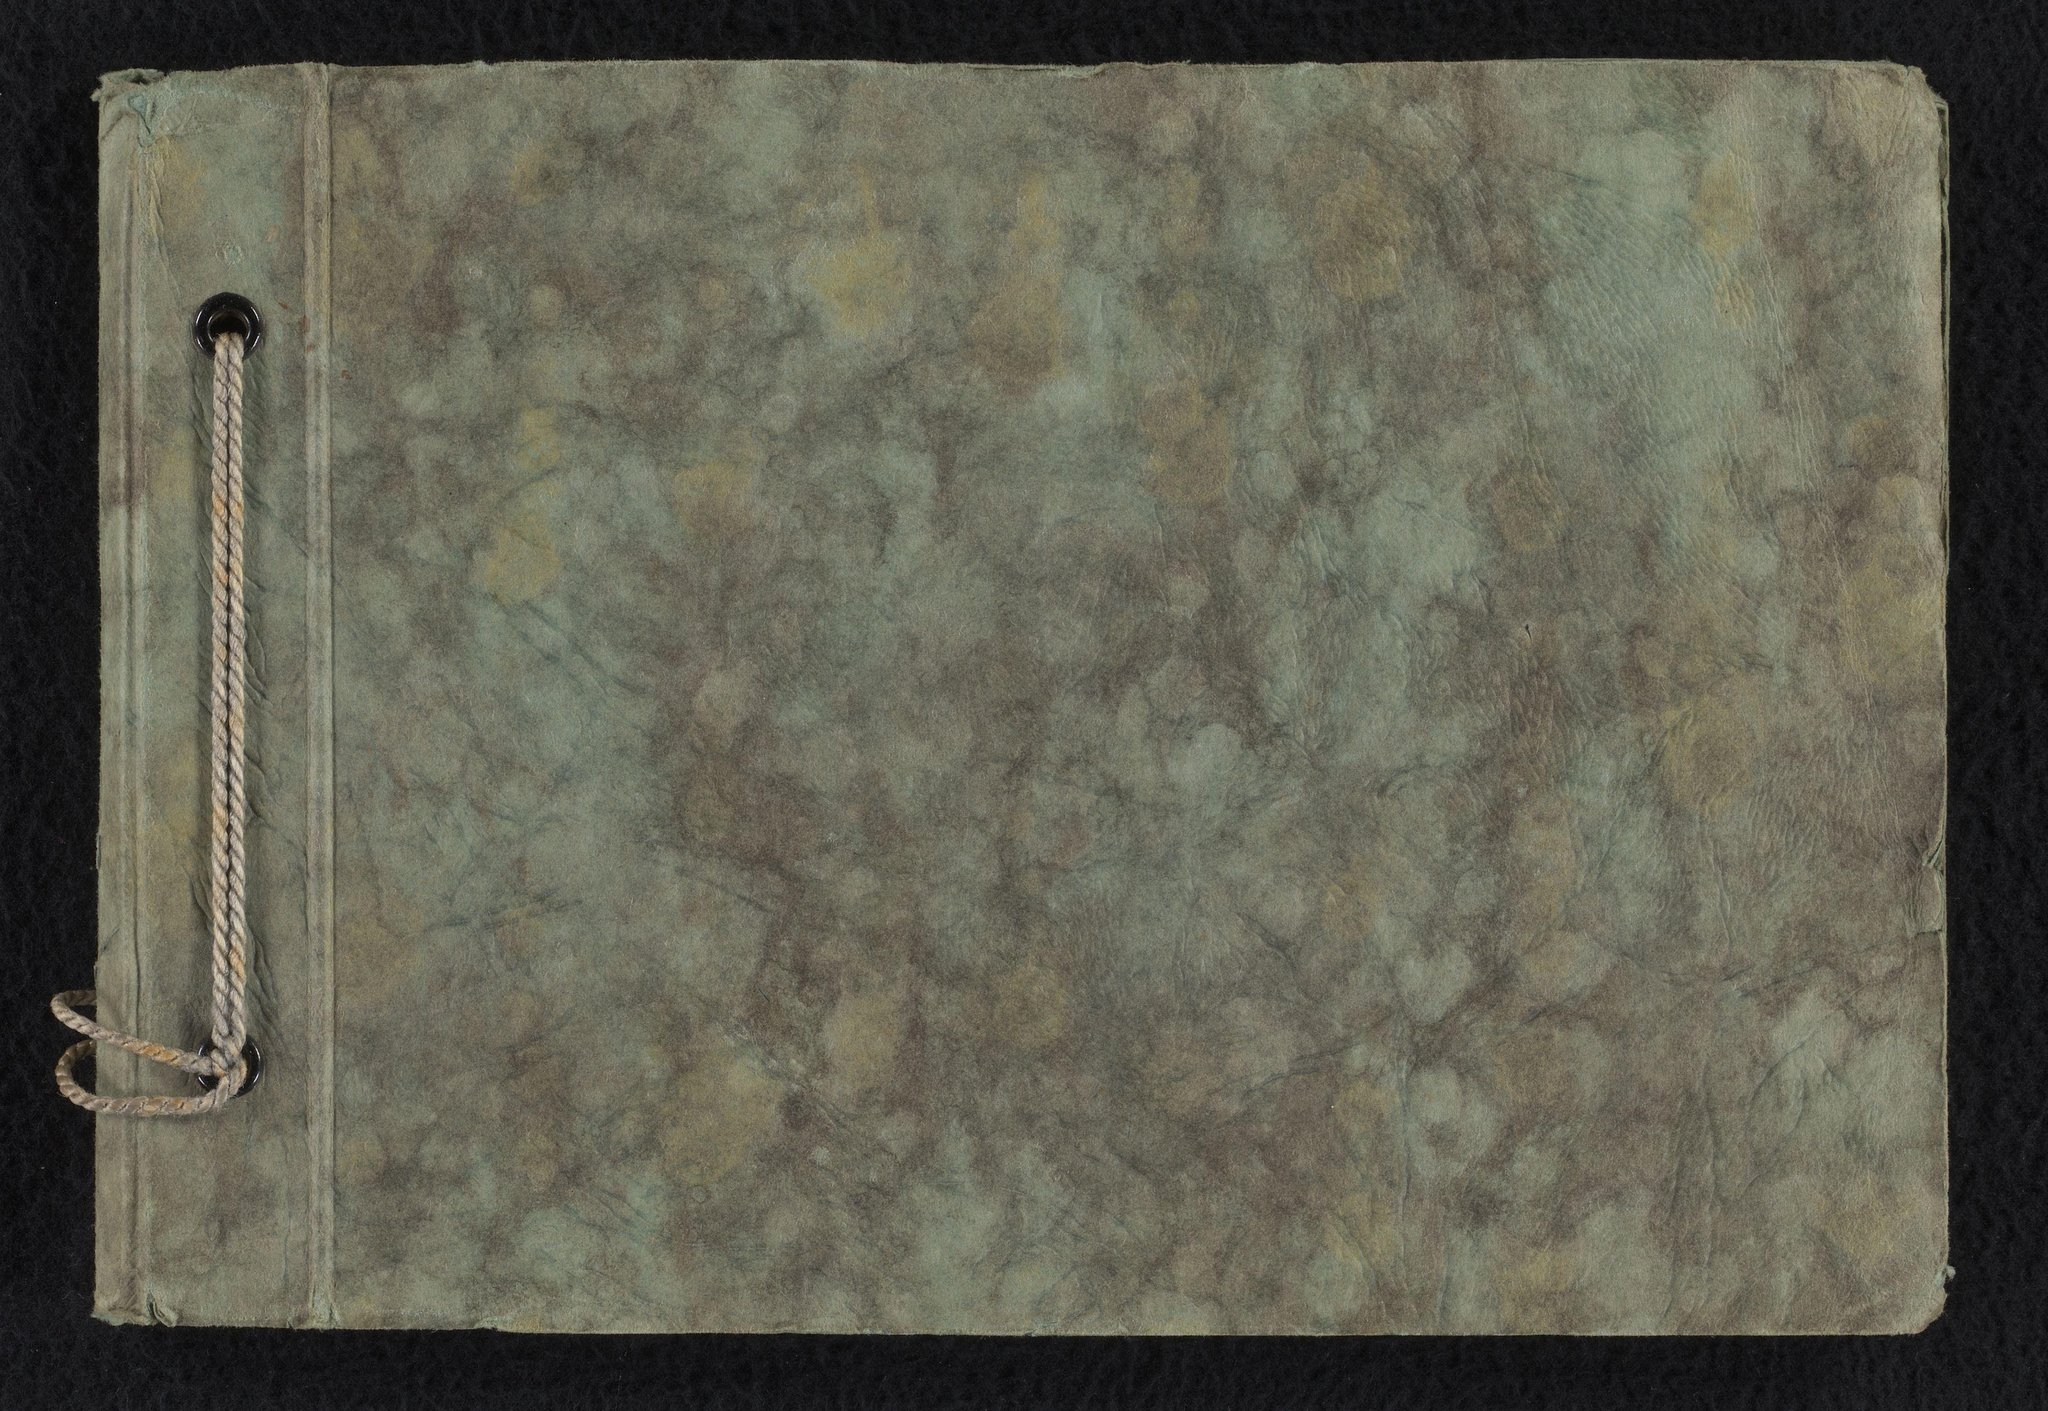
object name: slip in album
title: Fotoalbum met vakantiefoto's (van augustus 1932 tot augustus 1935)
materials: cardboard, photographic support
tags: eugen wachenheimer, else wachenheimer-moos, leiden, isabel wachenheimer-elon, germany, austria, switzerland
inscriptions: date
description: Bijschriften geschreven in het handschrift van Else Wachenheimer-Moos. Dit object is onderdeel van de nalatenschap van Isabel Elon-Wachenheimer (1928-2010). Tot haar overlijden behoorde het samen met de andere objecten uit de nalatenschap tot haar privédomein van Isabel Wachenheimer. In die particuliere context zijn deze objecten tezamen en individueel aandenkens - aan de jeugd, ouders en familie van Isabel Wachenheimer vóór en tijdens de Shoah en aan haar leven na de Tweede Wereldoorlog. Isabel Wachenheimer, die van juni 1943 tot mei 1945 gevangen zat in Kamp Westerbork, Theresienstadt, Auschwitz, Lenzing a/d Oberdonau (een buitenkamp van Mauthausen), overleefde de Shoah. Haar ouders – Eugène Wachenheimer en Else Wachenheimer-Moos - werden op 14 oktober 1944 in Auschwitz-Birkenau vermoord.